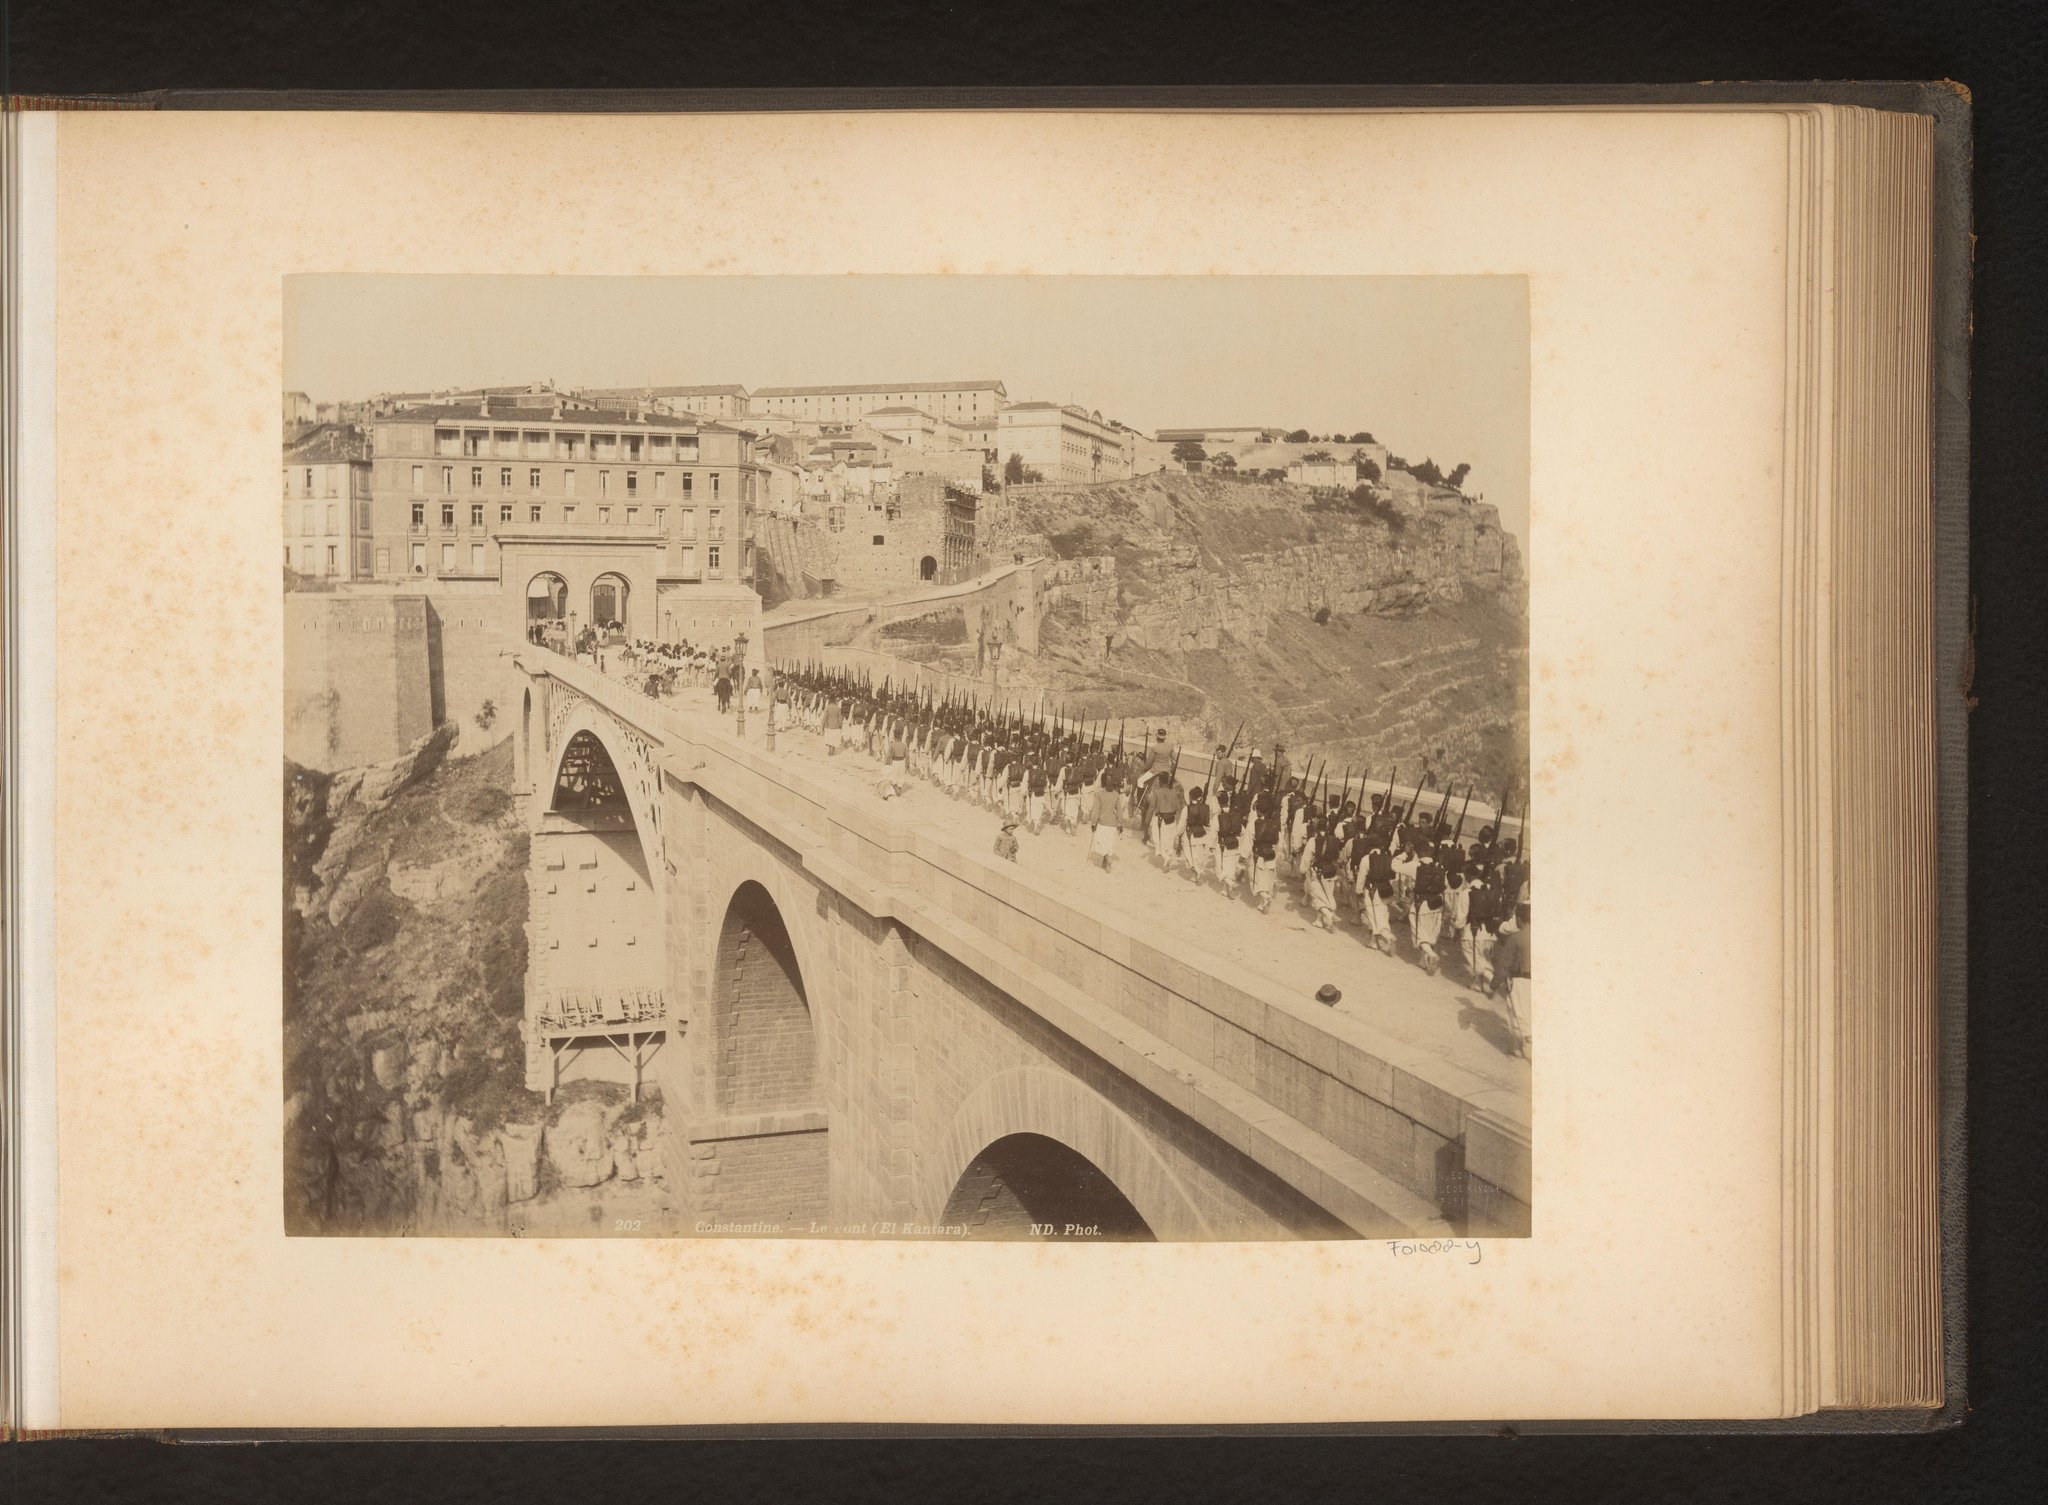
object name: photograph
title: Militairen op de El Kantera bij Constantine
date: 1880-1900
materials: photographic support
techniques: albumen print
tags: city-view, and landscape with man-made constructions, the soldier; the soldier's life, bridge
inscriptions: number: ‘202’, check stamp: ‘J. Kuhn Editeur/ 220 Rue de Rivoli Paris’